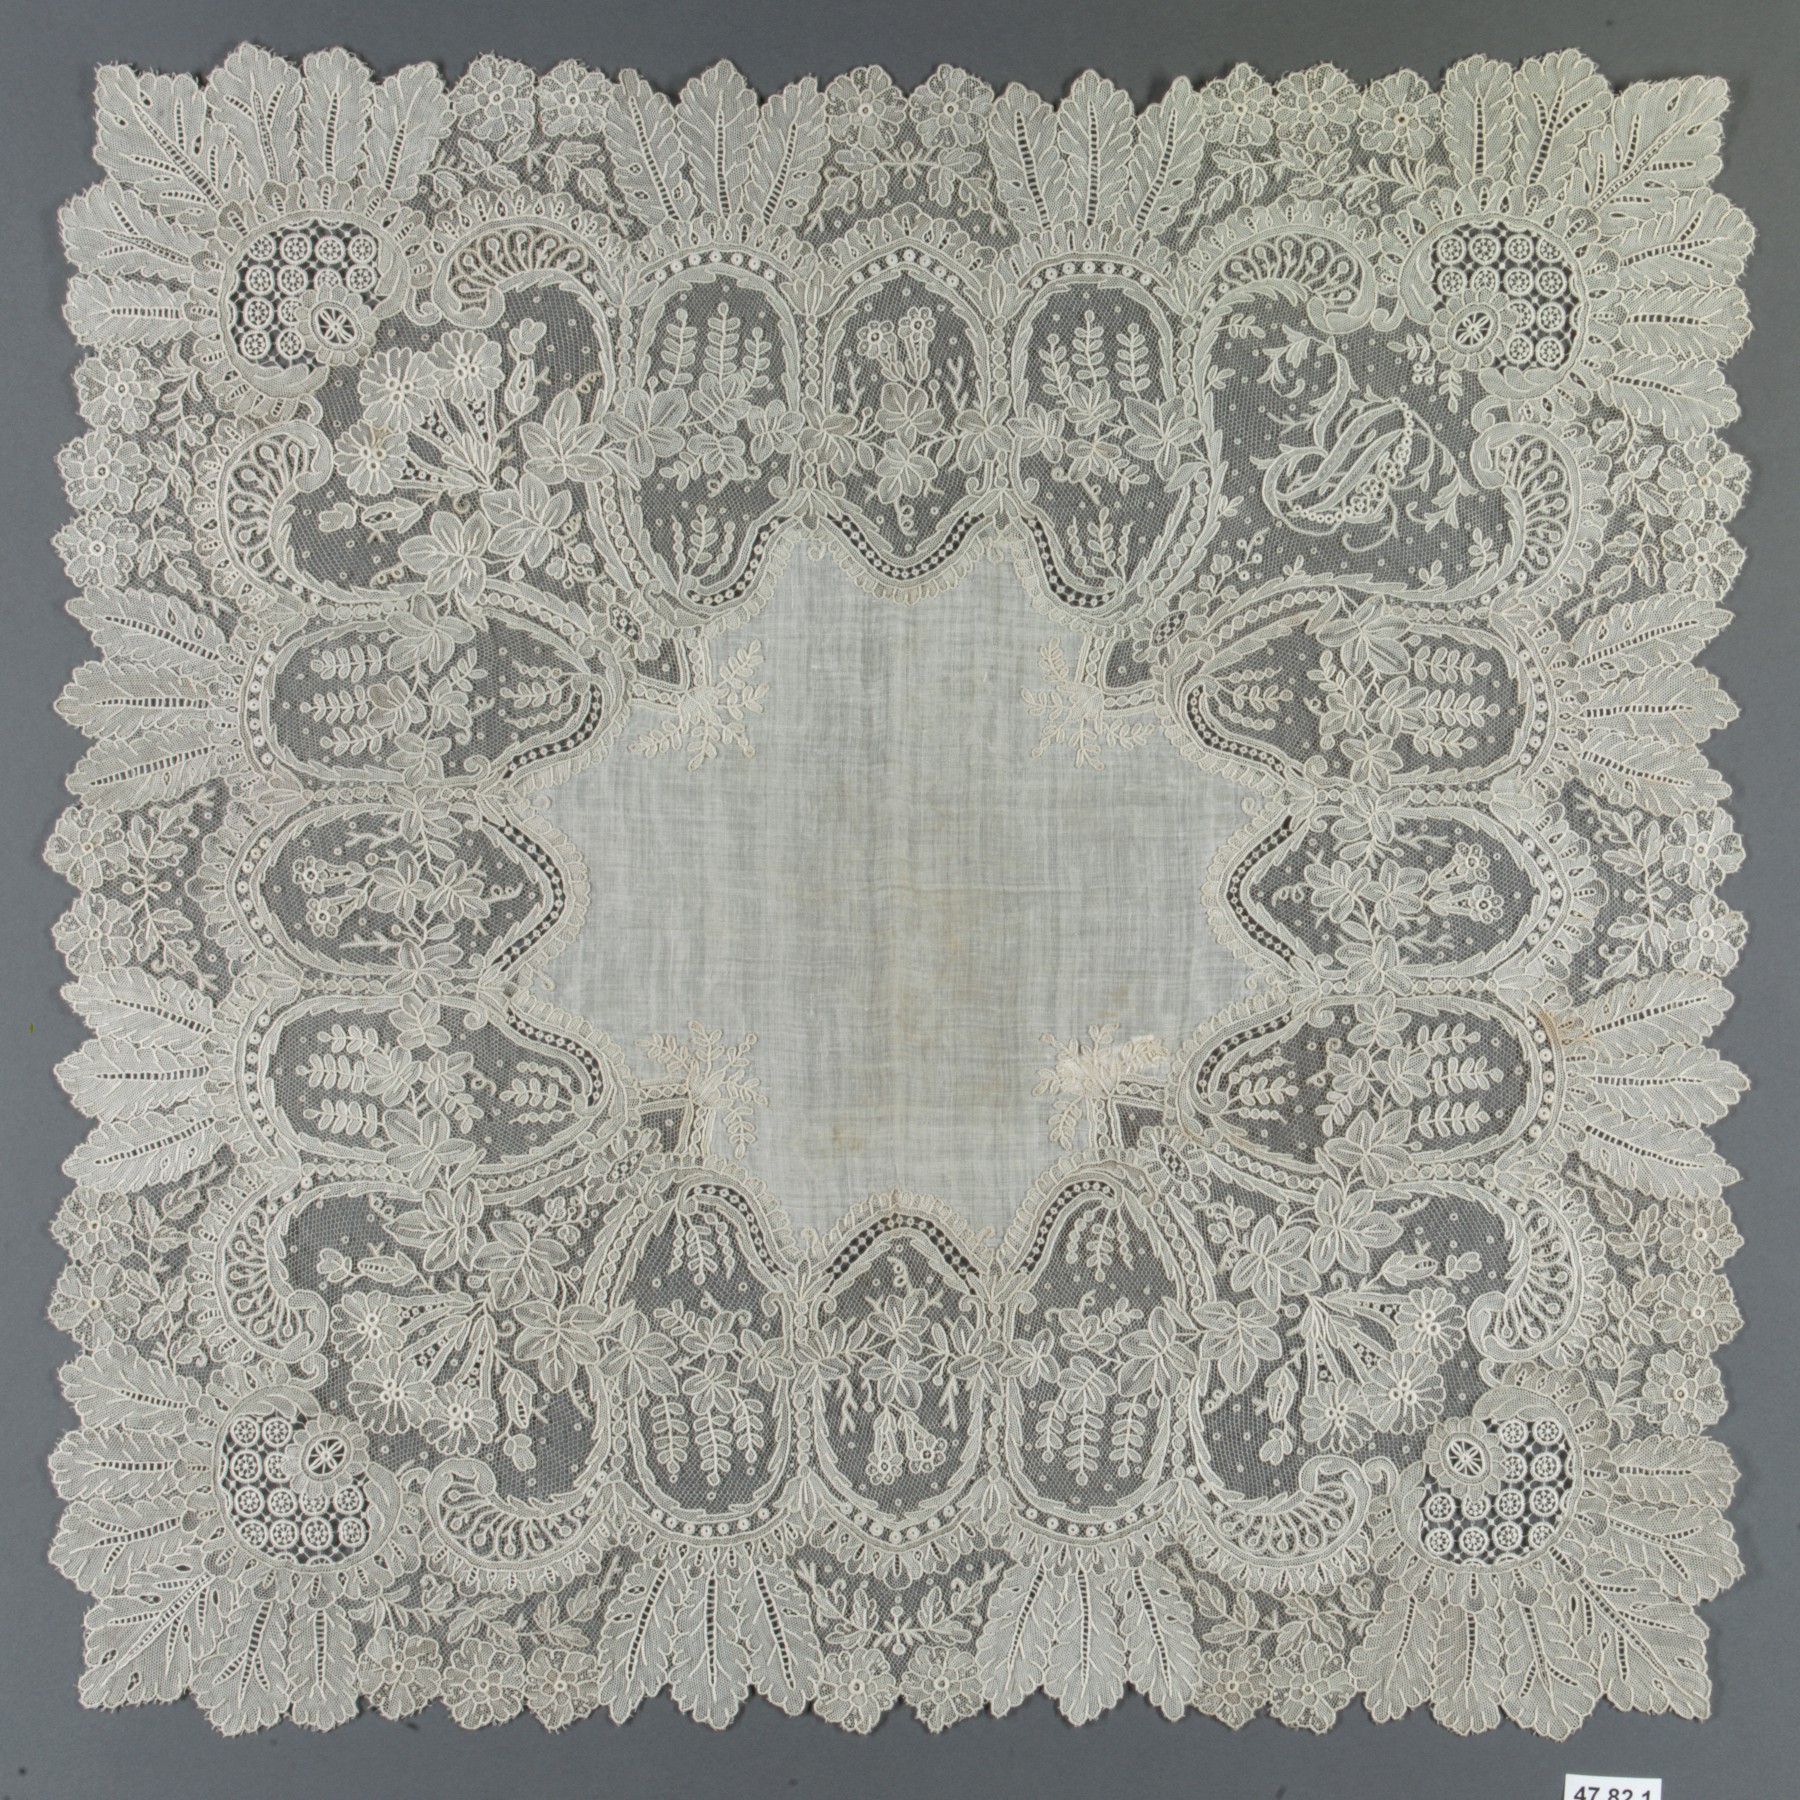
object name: handkerchief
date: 1860-1880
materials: linen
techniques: lace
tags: flowers